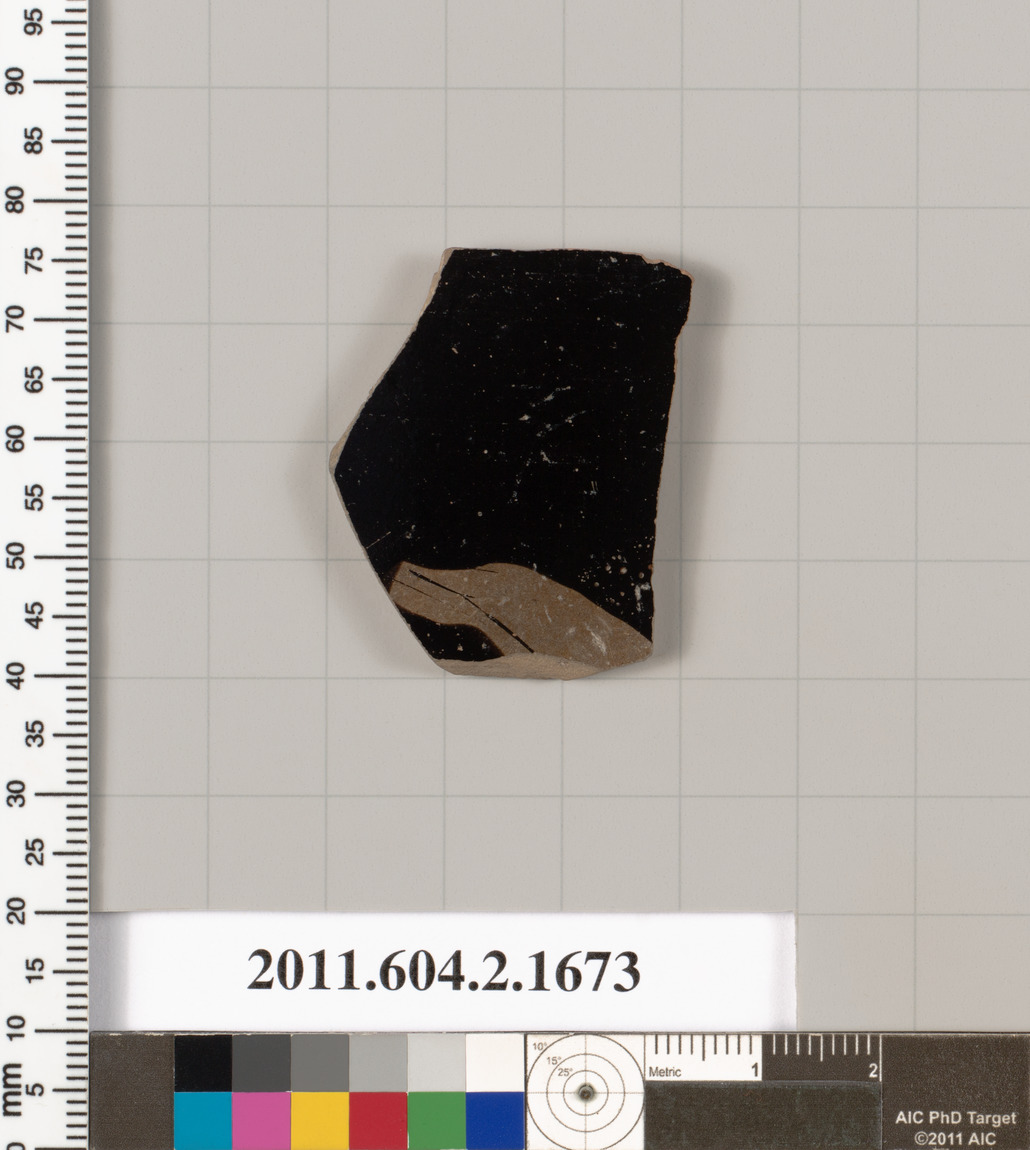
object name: skyphos fragment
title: Terracotta fragment of a skyphos (deep drinking cup)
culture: greek, attic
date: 450-401 BCE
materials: terracotta